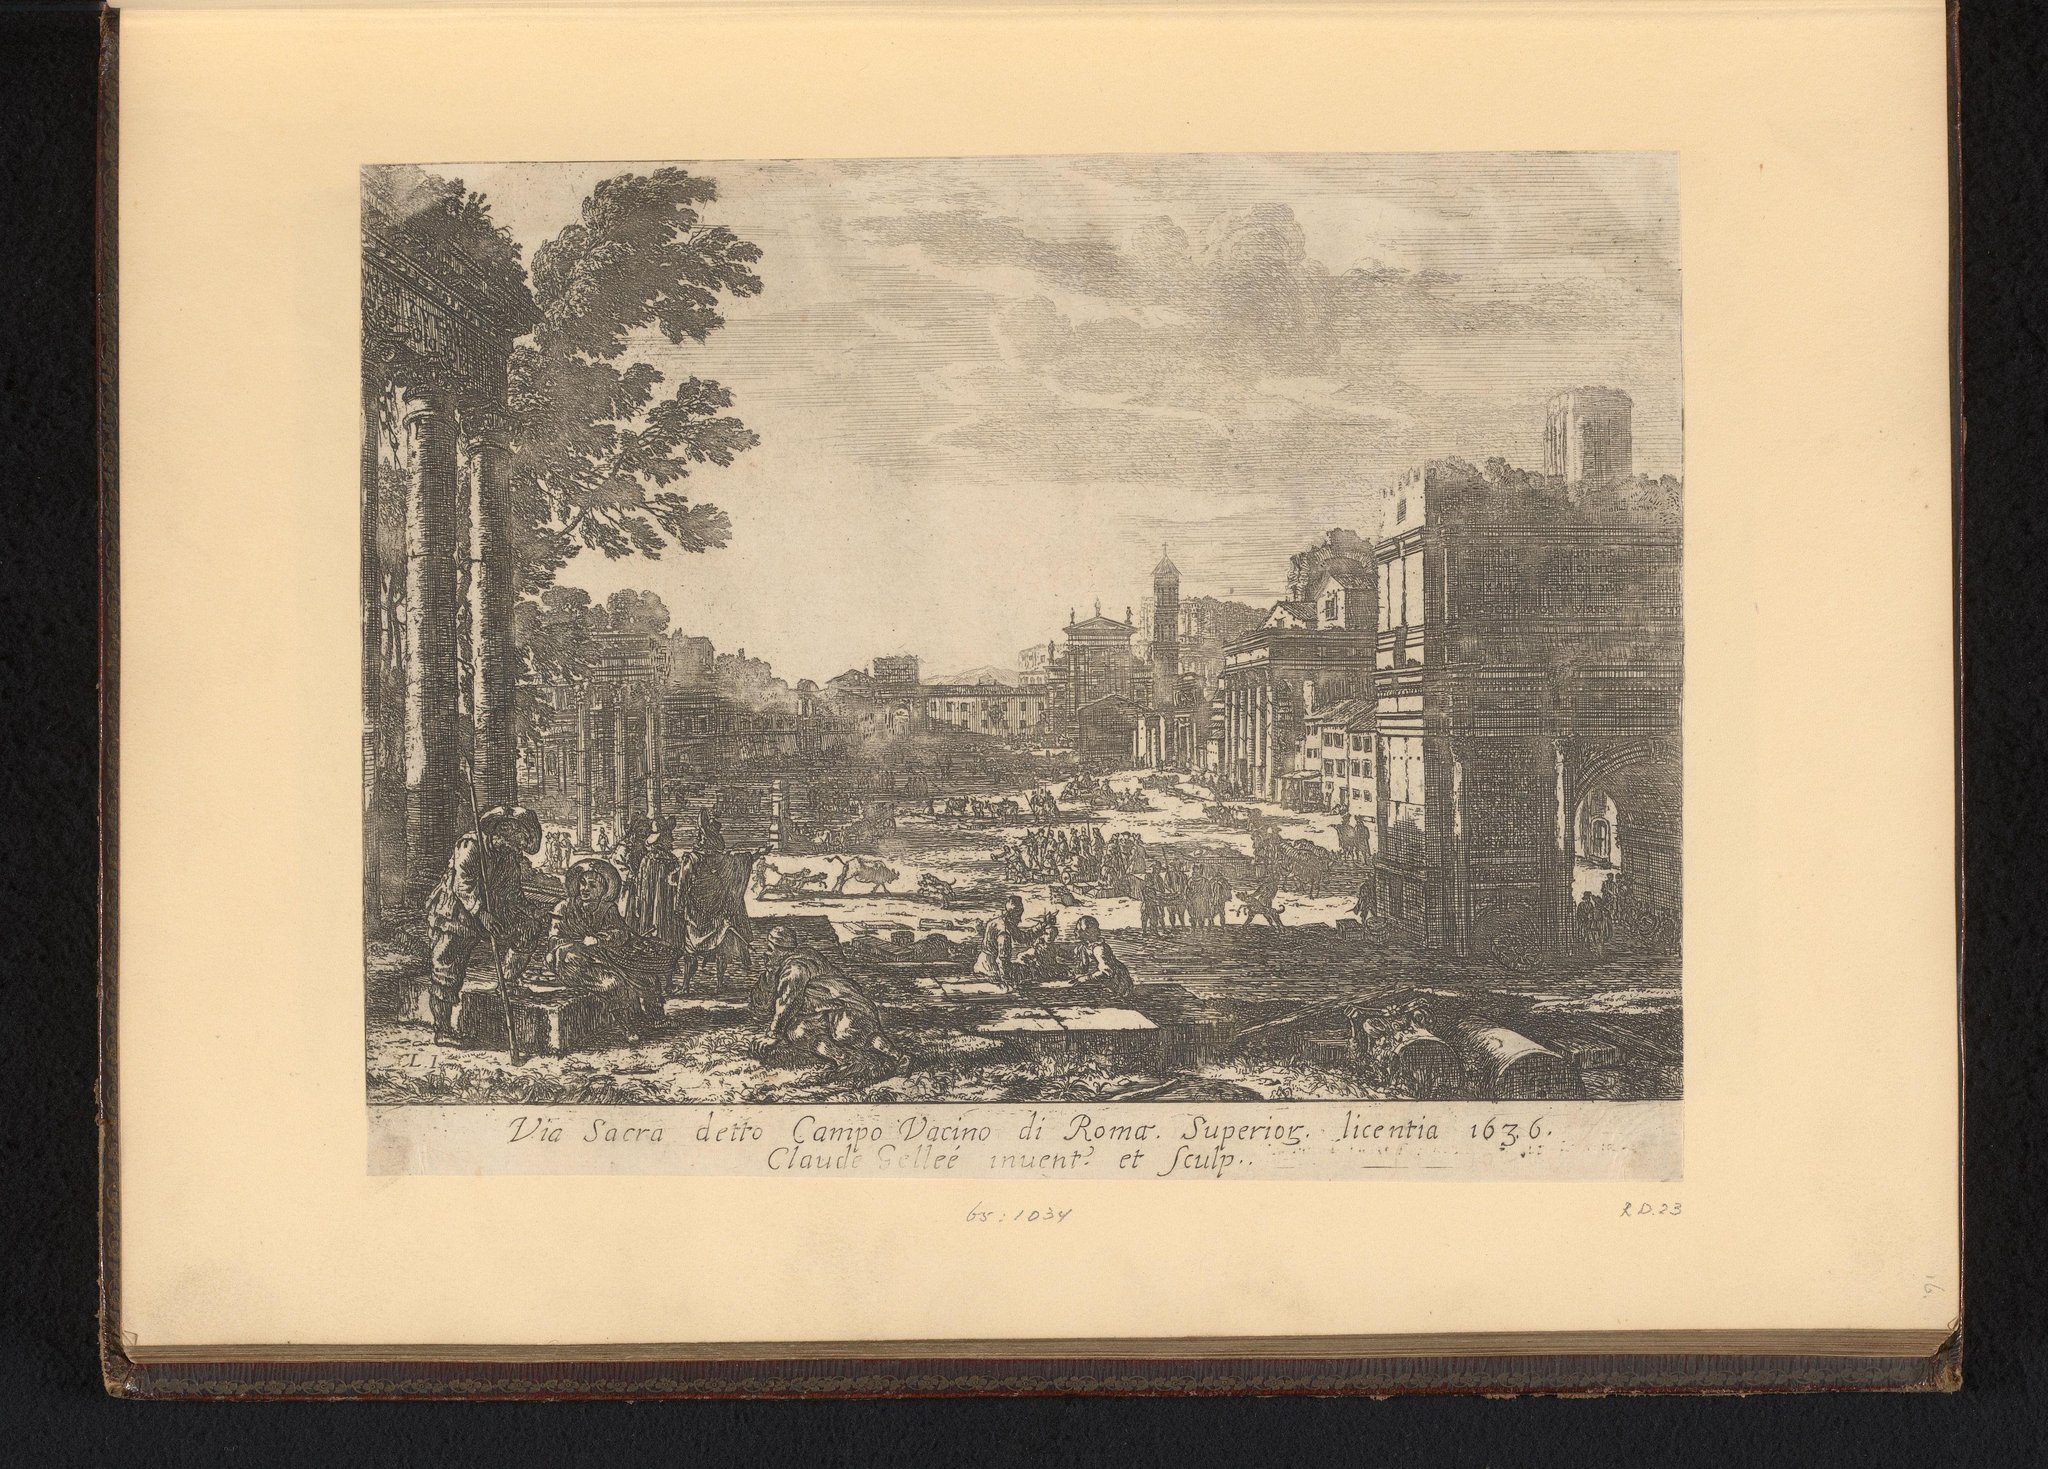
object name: print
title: Forum Romanum te Rome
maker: claude lorrain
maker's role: draughtsman, print maker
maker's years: 1604-1682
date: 1636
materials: paper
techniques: etching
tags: landscape with ruins (+ city(-scape) with figures, staffage), square, place, circus, etc. (+ city(-scape) with figures, staffage)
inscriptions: date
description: Prent maakt mogelijk deel uit van een serie van 200 prenten. Deze serie is onder de titel 'A Collection of two hundred original etchings' voor het eerst uitgegeven door J.M. Greery in 1816.